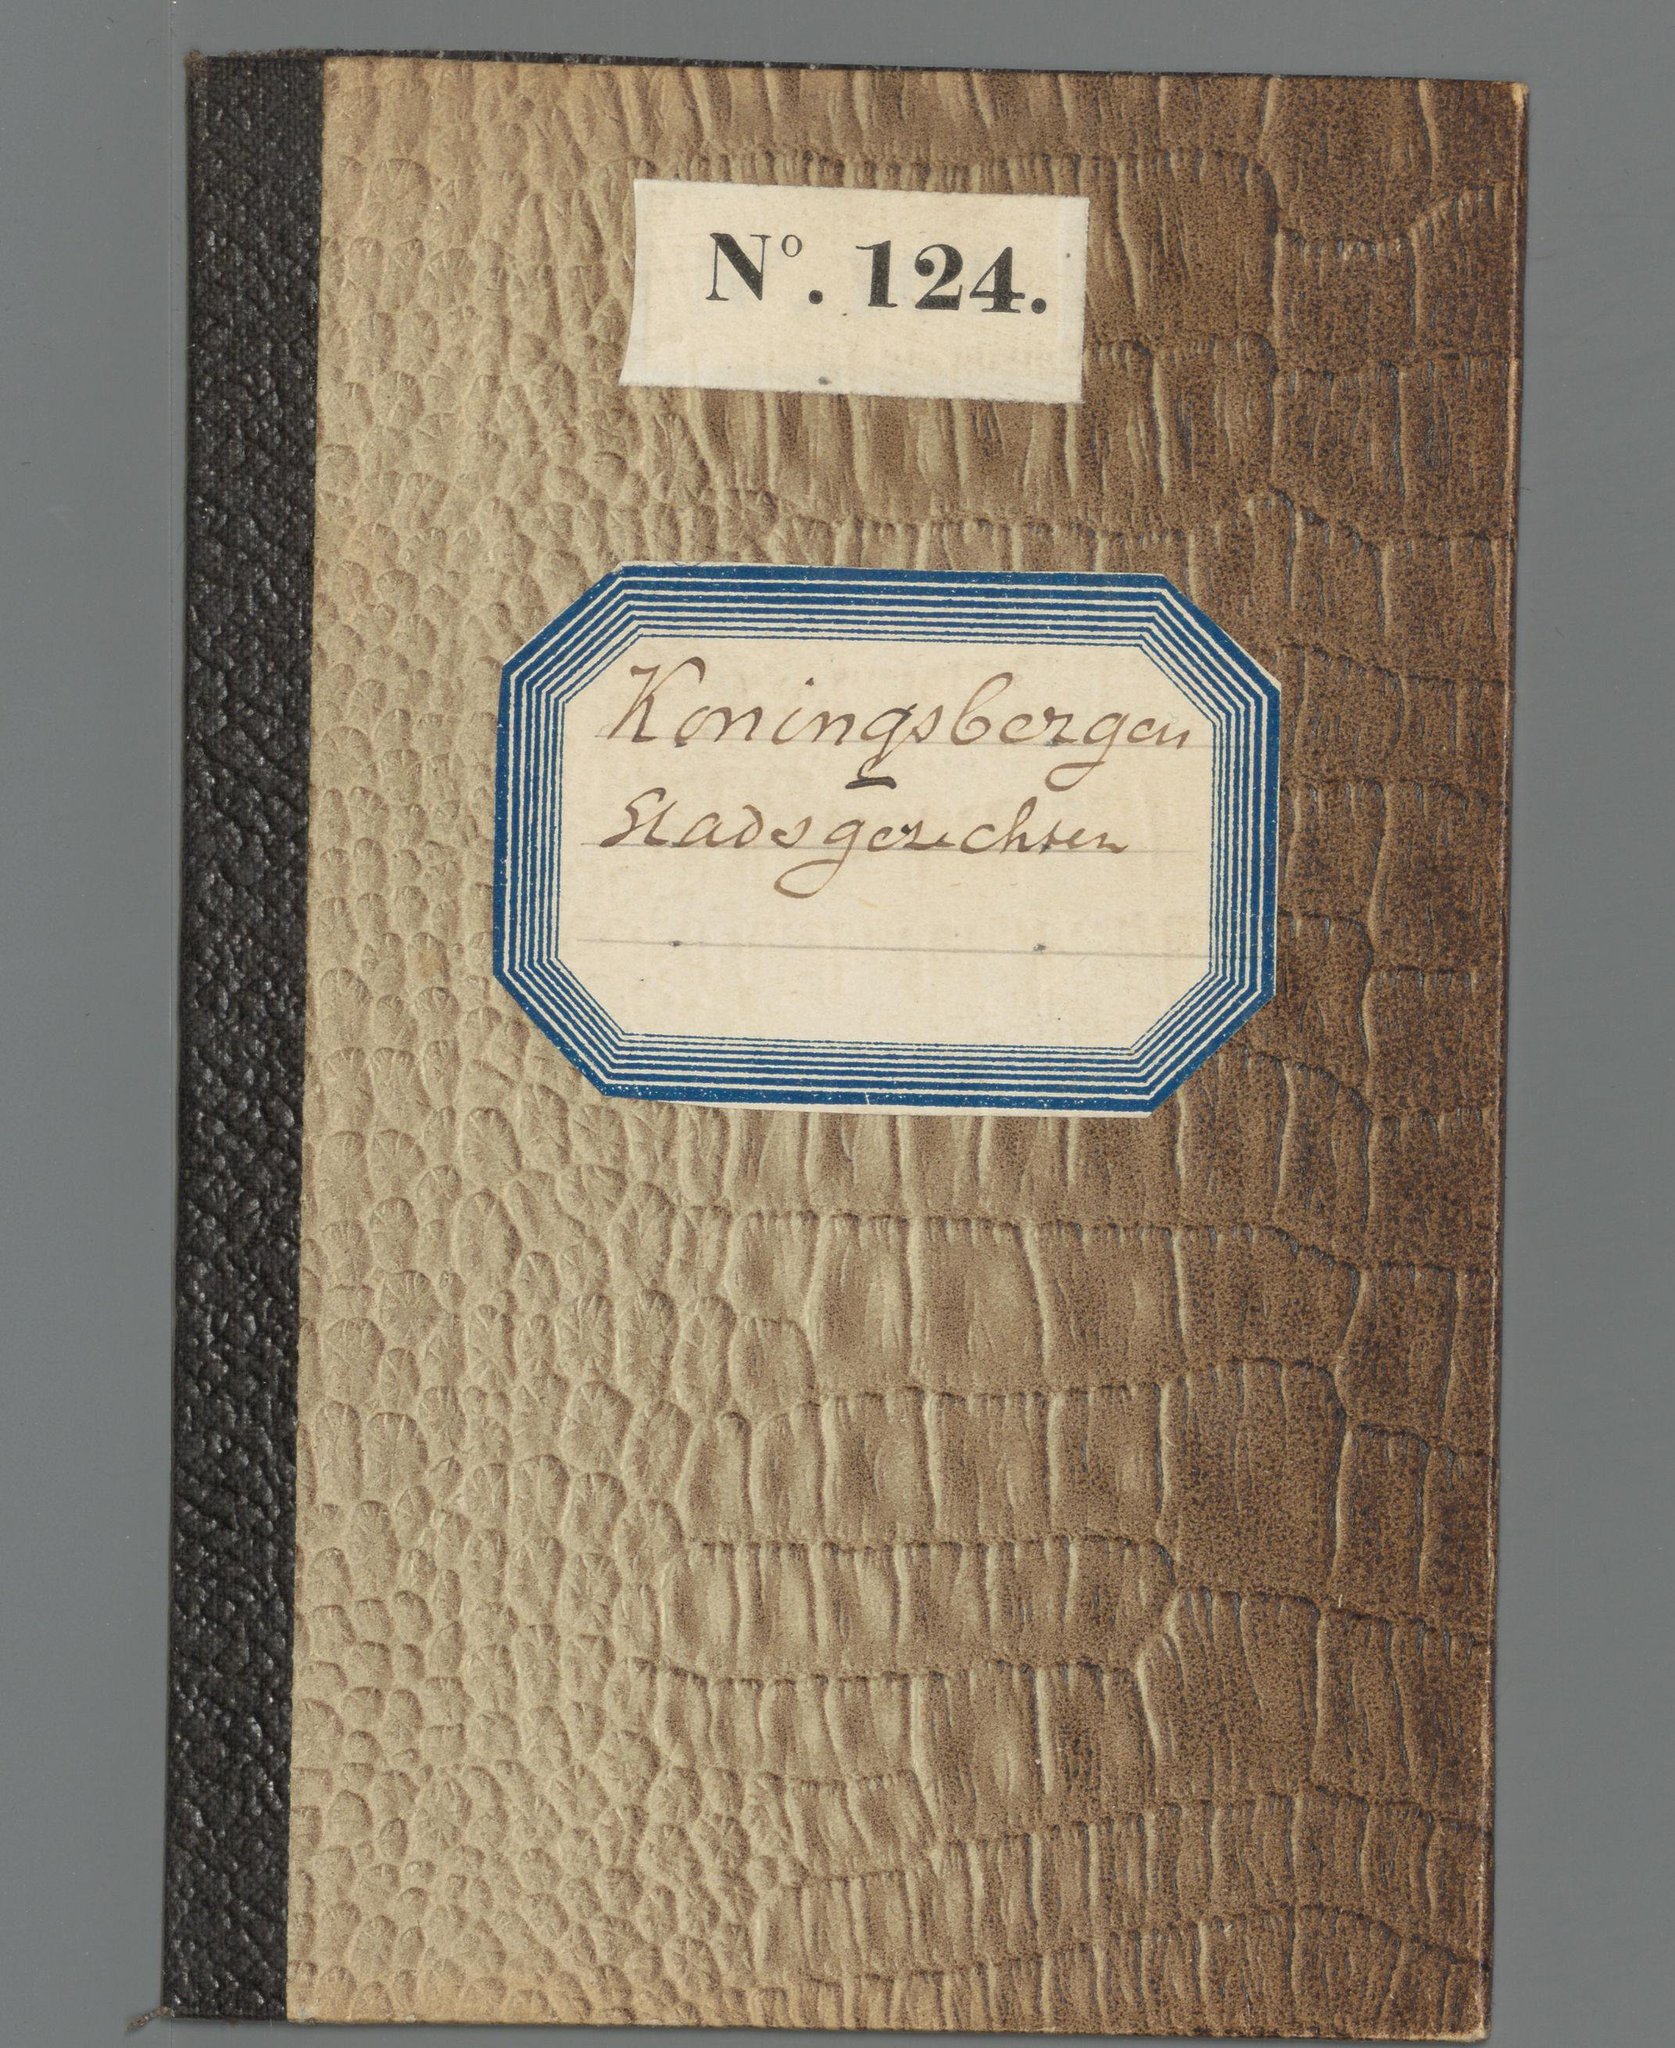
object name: wrapper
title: Koningsbergen. Stadsgezichten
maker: Anonymous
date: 1900-1950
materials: cardboard, paper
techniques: lithograph, writing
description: In de omslag zit een kaart ingestoken met daarop een korte beschrijving van de inhoud.